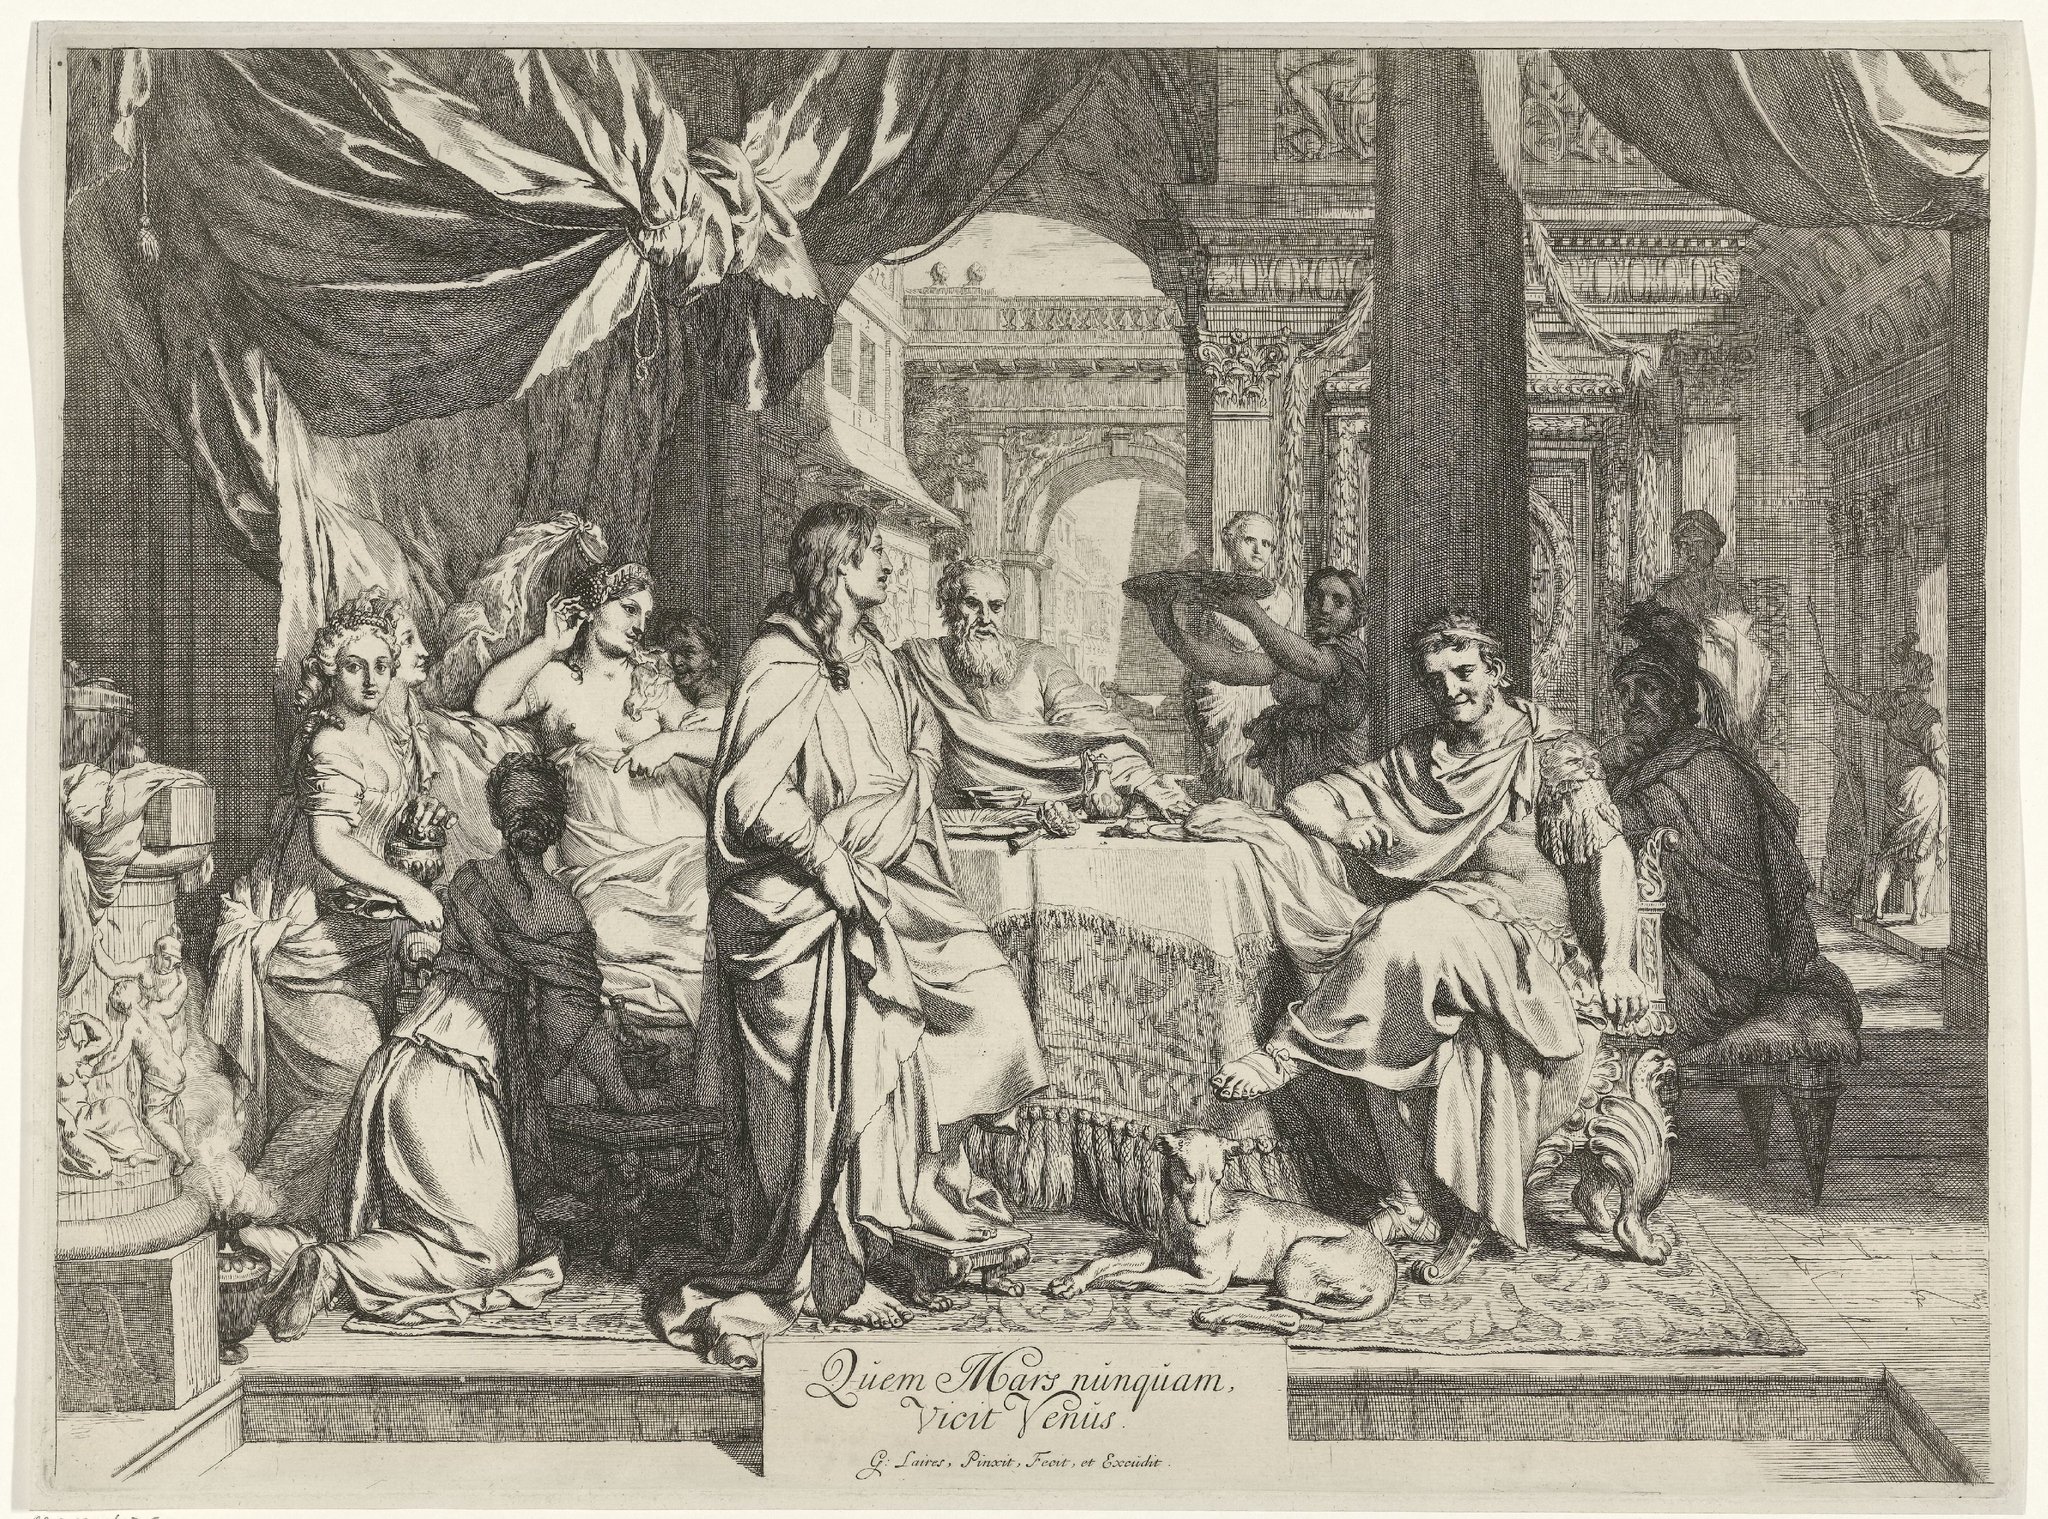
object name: print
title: Quem Mars nunquam, vicit Vénus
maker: gerard de lairesse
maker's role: draughtsman, painter, print maker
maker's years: 1641-1711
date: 1675-1680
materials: paper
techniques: etching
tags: banquet of mark antony and cleopatra: she dissolves a pearl in a cup of wine, which she then drinks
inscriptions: collector's mark: Lugt 240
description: Het feestmaal van Cleopatra in een paleisinterieur. Links ligt Cleopatra met ontblote borsten aan tafel, rechts zit Marcus Antonius. Rond de tafel staan verschillende gasten en leden van de hofhouding. Voorgesteld is het moment waarop Lucius Plancus verhindert dat Cleopatra een tweede parel uit haar oorbel neemt om in haar wijn op te laten lossen. Hierdoor verliest Marcus Antonius de weddenschap om wie het duurste banket kon geven. Op de grond voor de tafel ligt een jachthond.